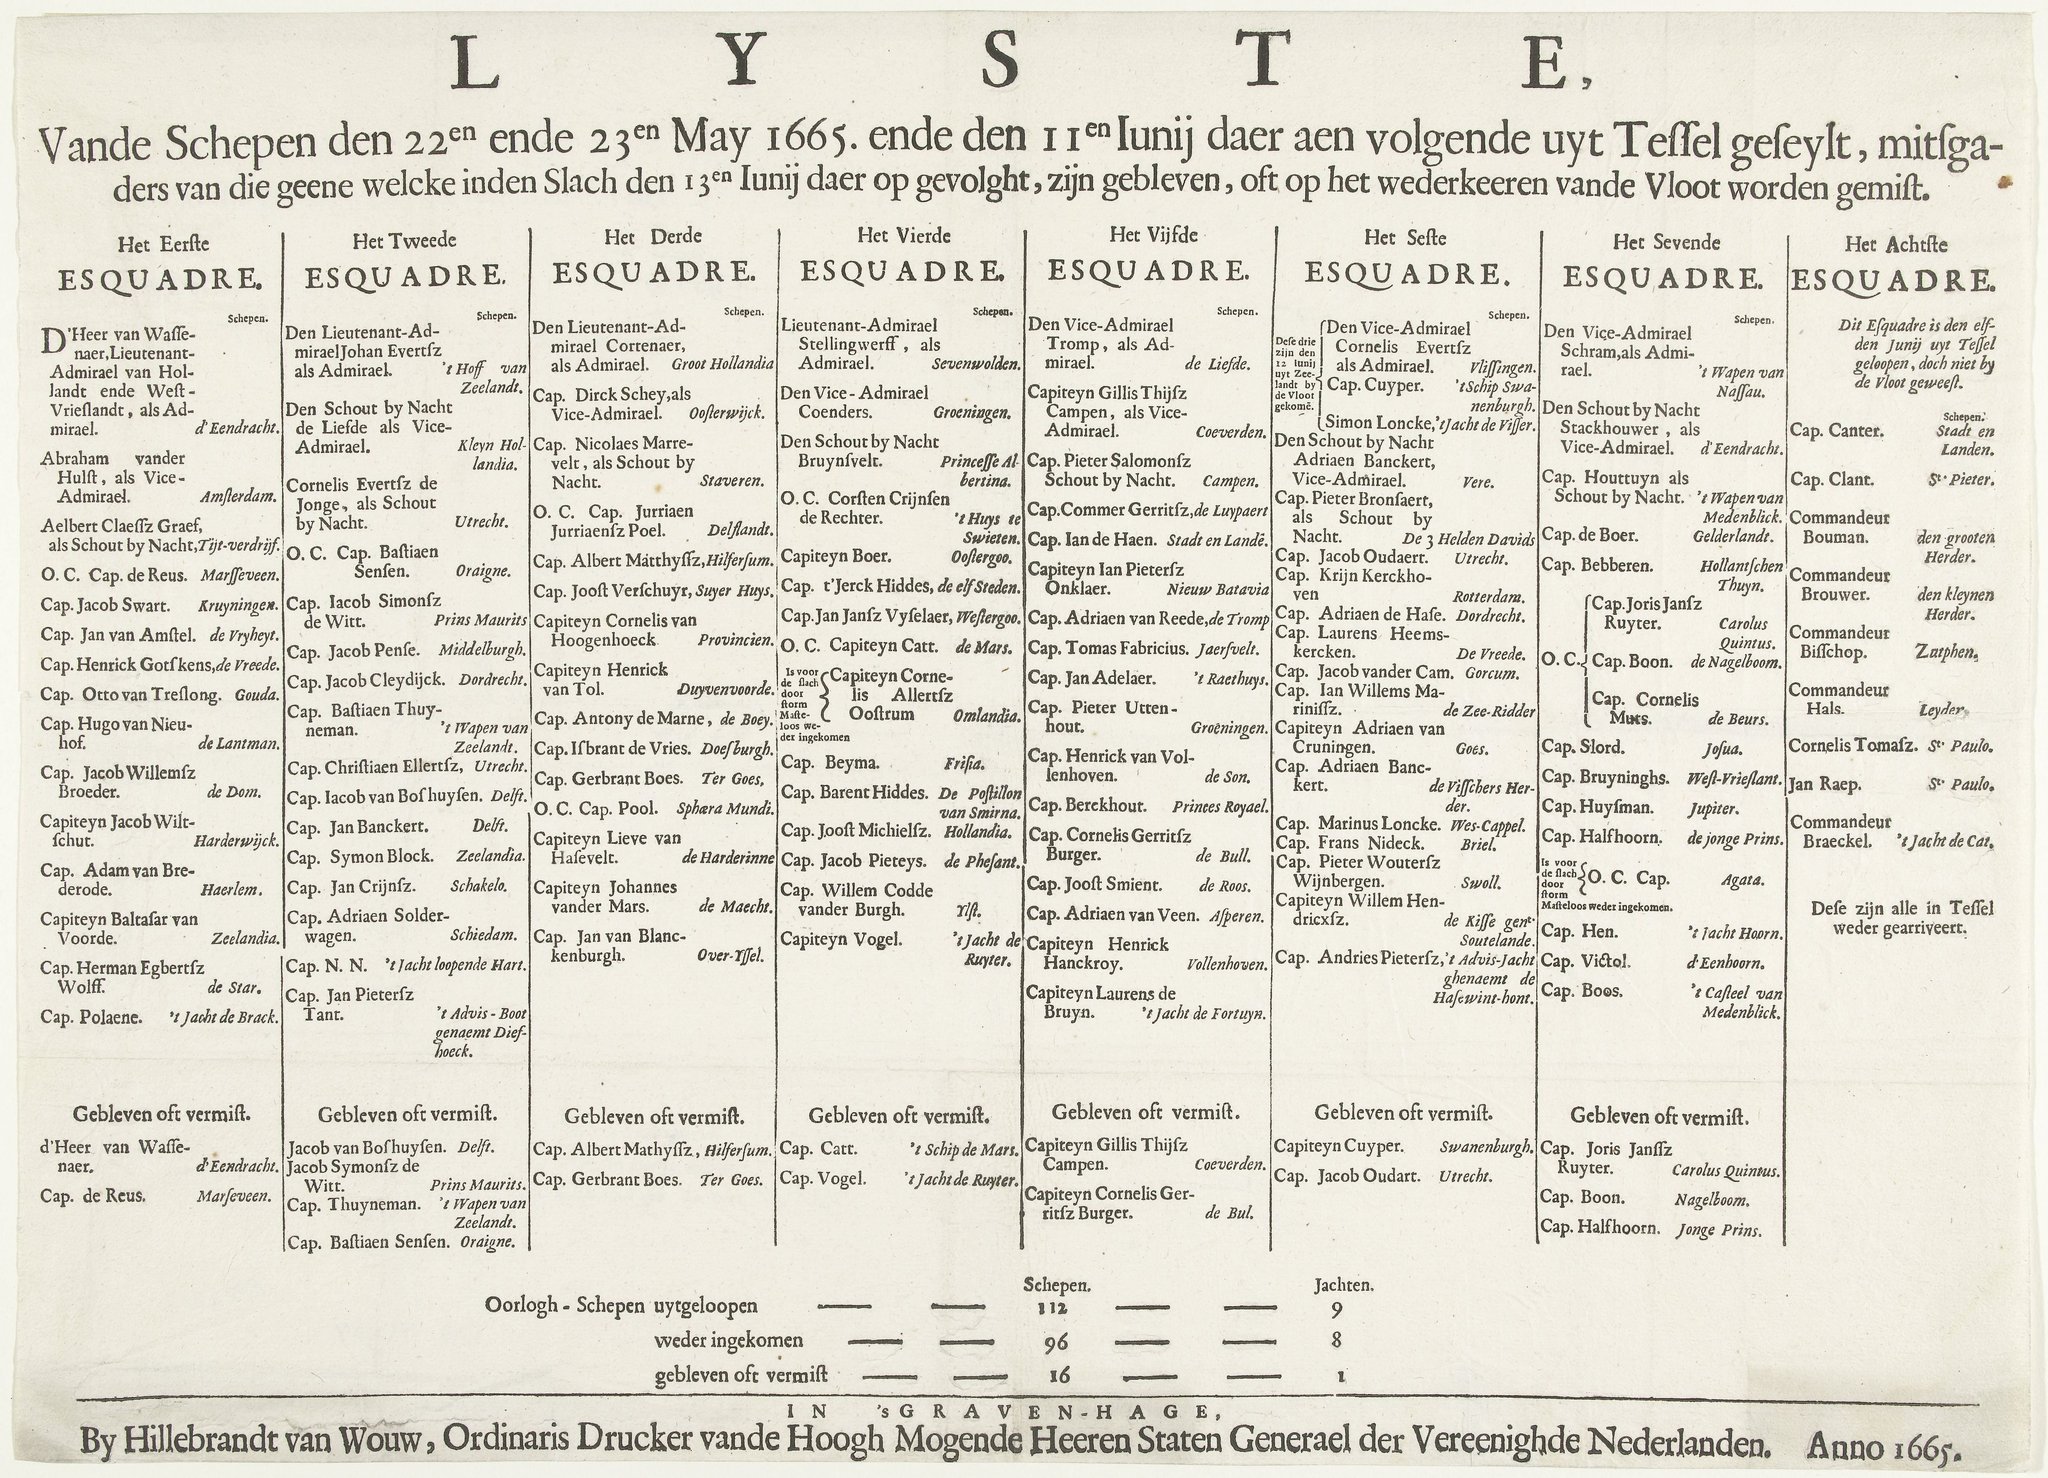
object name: text sheet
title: Lyste, Vande Schepen den 22en ende 23en May 1665. ende den 11en Junij daer aen volgende uyt Tessel geseylt, mitsgaders van die geene welcke inden Slach den 13en Junij daer op gevolght, zijn gebeleven, oft op het wederkeeren vande Vloot worden gemist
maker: hillebrant jacobsz. van wouw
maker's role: printer, publisher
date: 1665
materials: paper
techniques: letterpress printing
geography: the hague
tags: battle of lowestoft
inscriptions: date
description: Lijst van de schepen van de Staatse vloot in de acht eskaders die in mei en juni vanuit Texel gezeild zijn; met onderaan de lijst van 16 schepen die sinds de zeeslag bij Lowestoft op 13 juni 1665 worden vermist.